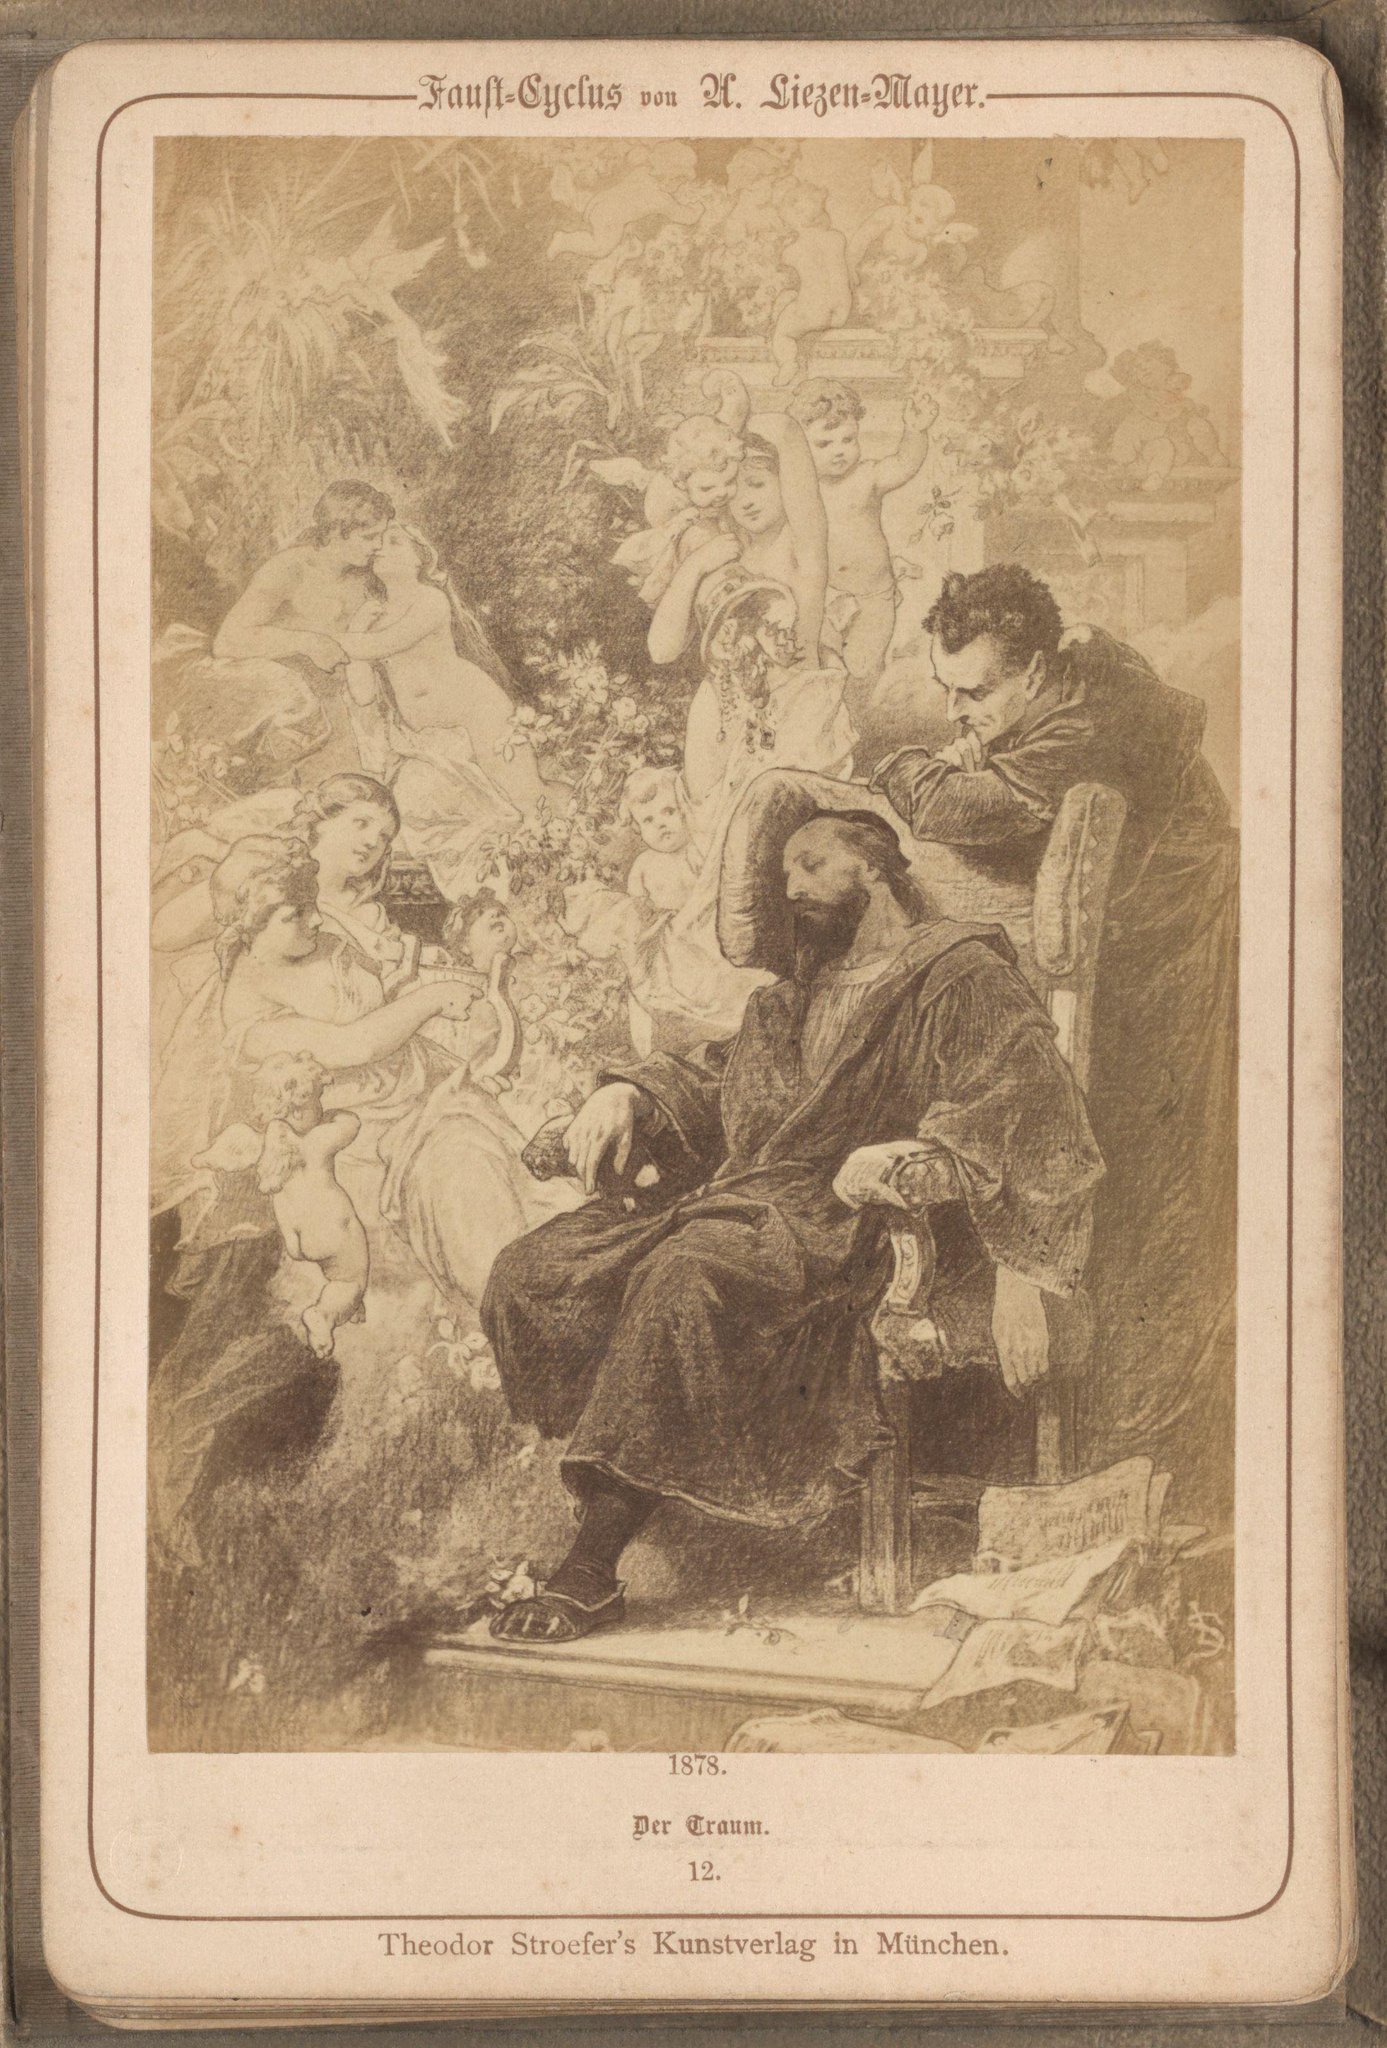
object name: photograph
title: Fotoreproductie van (vermoedelijk) een tekening getiteld 'De droom'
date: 1878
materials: cardboard, paper, photographic support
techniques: albumen print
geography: munich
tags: armchair, seat, faust, garden of eden, paradise, dream, mephistopheles, name of the demonic tempter in the literary versions of the faust legends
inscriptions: check stamp: ‘TS’, number: ‘12’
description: Onderdeel van Album met 30 fotoreproducties van tekeningen van het Faust-verhaal van J.W. von Goethe.